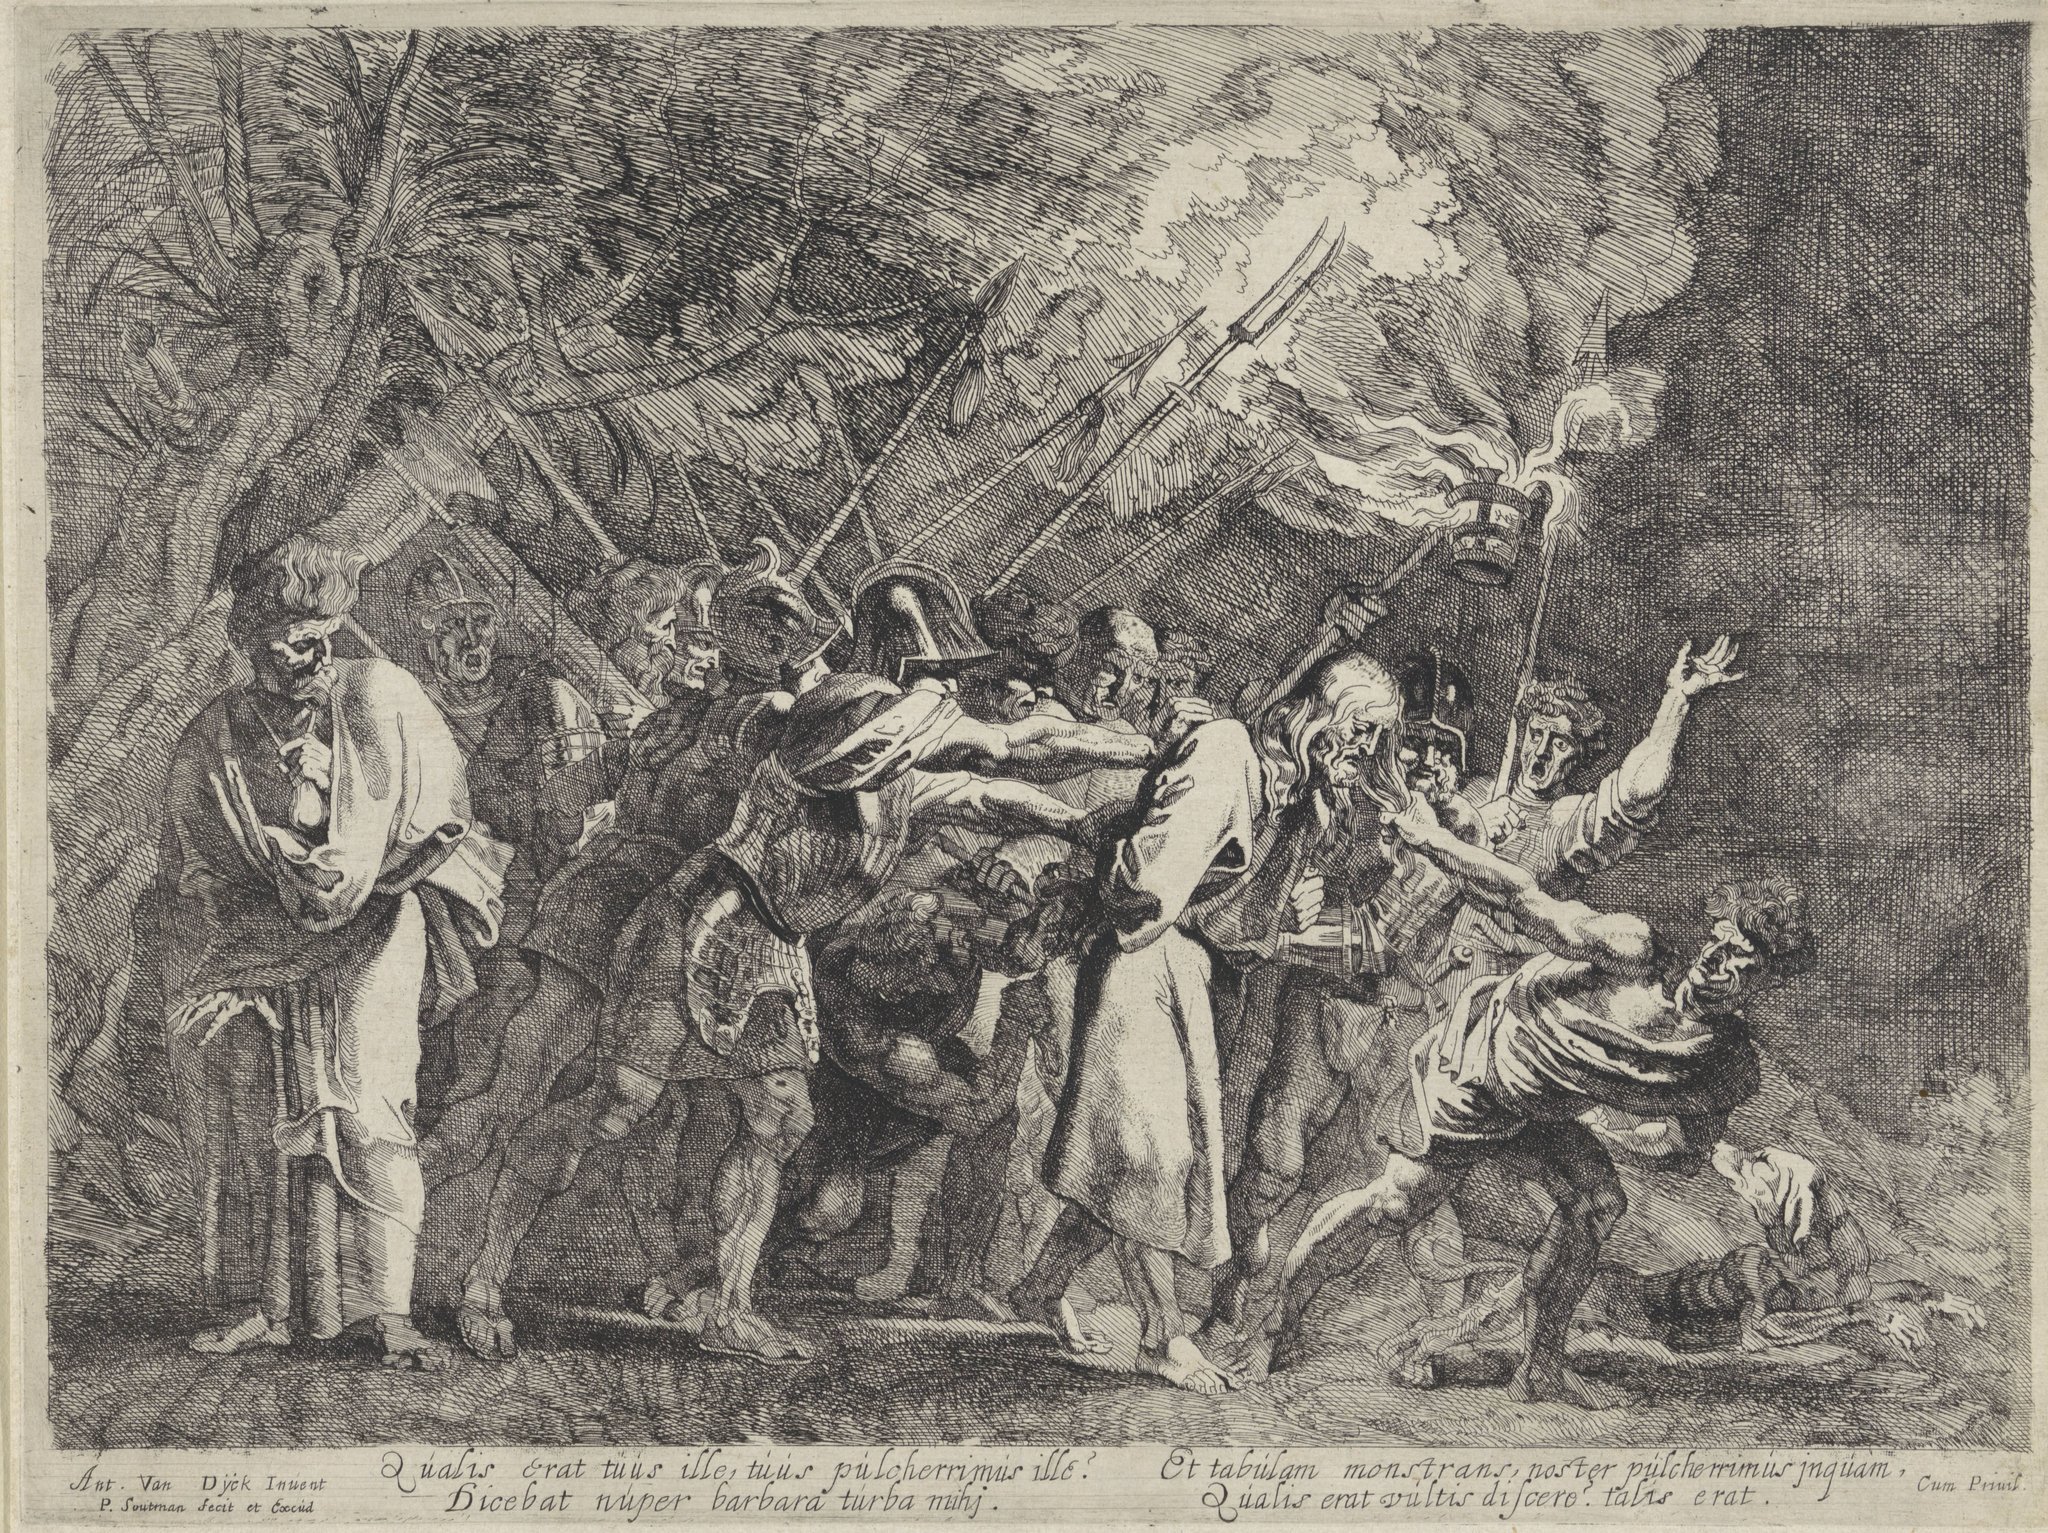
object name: print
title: Gevangenneming van Christus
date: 1616-1657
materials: paper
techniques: etching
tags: the arrest of christ ~ garden of gethsemane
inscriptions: collector's mark: Lugt 240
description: Christus wordt gevangen genomen op de Olijfberg nadat hij door Judas is verraden. Links staat Judas, die de geldbuidel om zijn hals vasthoudt. Christus wordt door de soldaten voortgeduwd en wordt daarbij aan zijn haren getrokken. Verbeelding van het Bijbelvers Joh. 18:6. Onder de voorstelling vier versregels in het Latijn van de hand van Poolse dichter Maciej Kazimierz Sarbiewski.